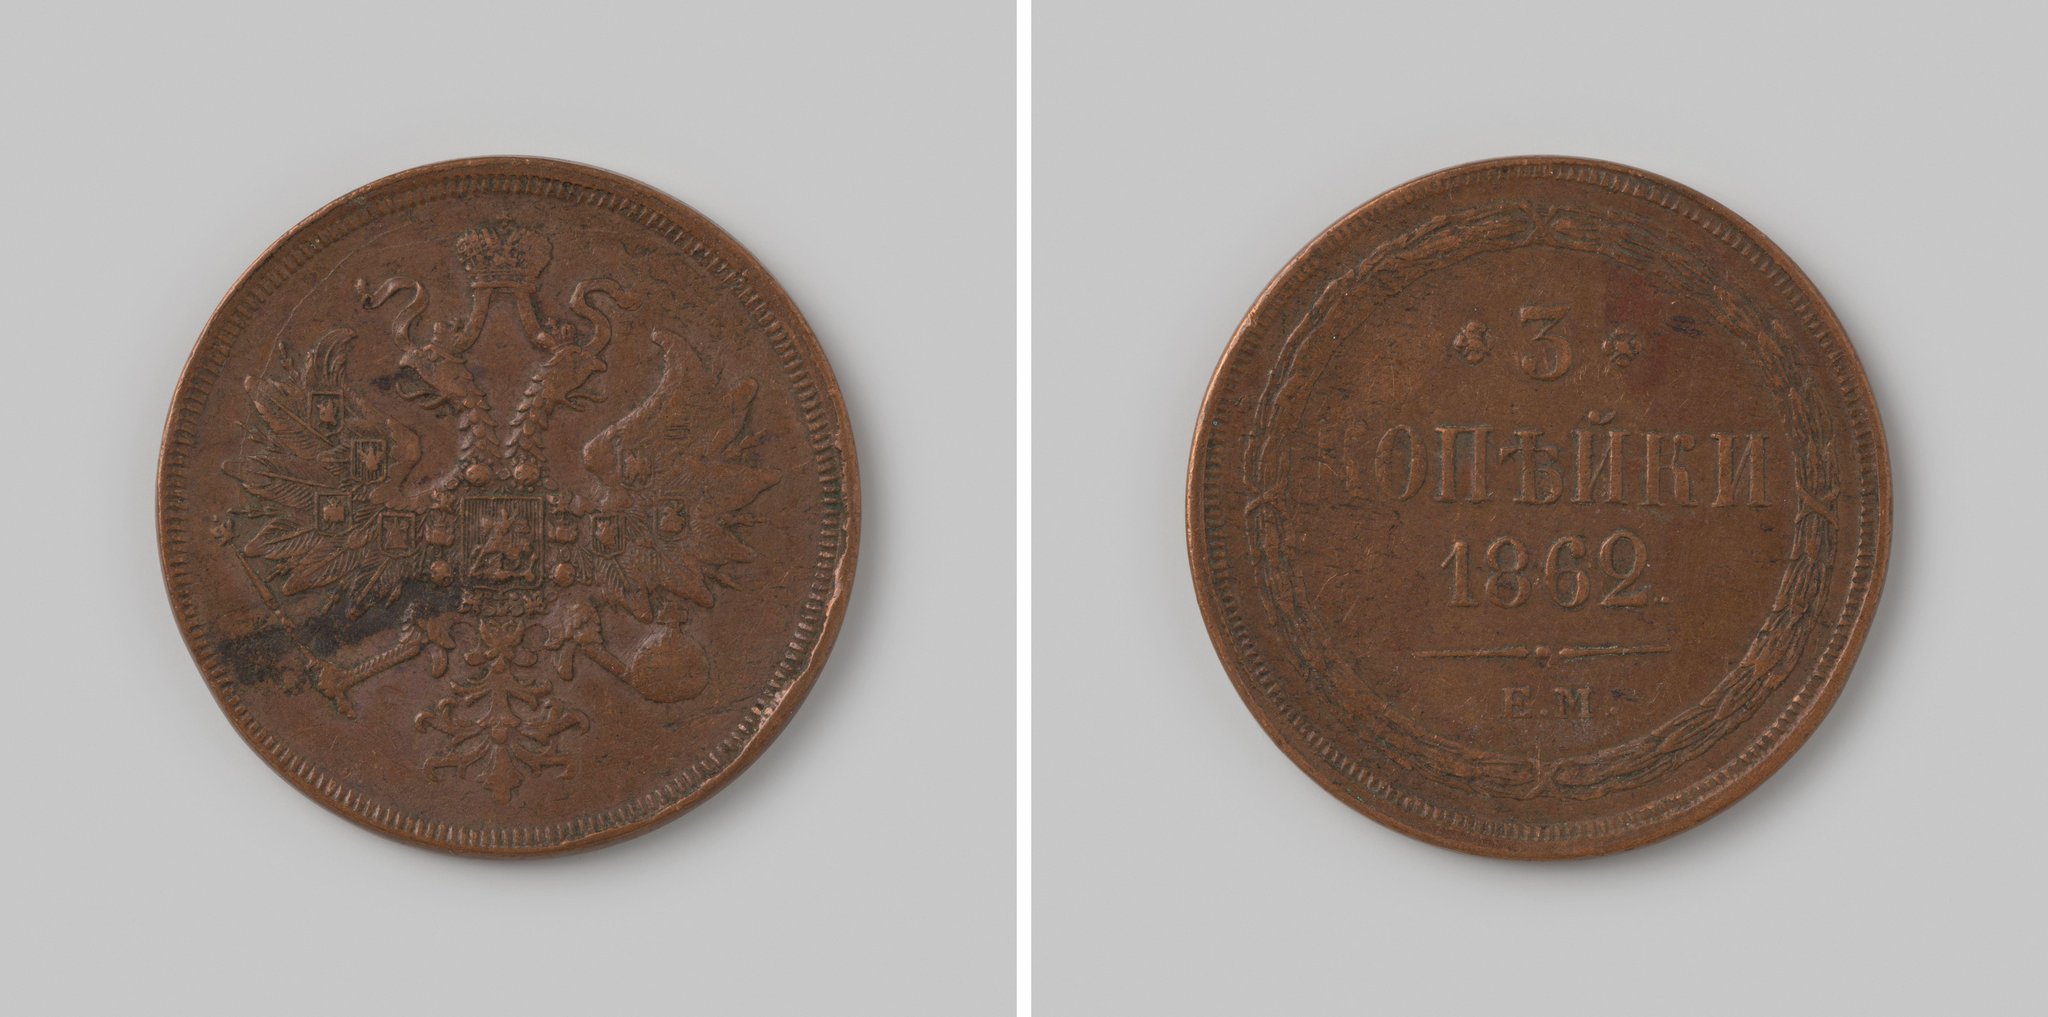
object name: coin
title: 3 kopeken uit Rusland van tsaar Alexander II, 1862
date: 1862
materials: copper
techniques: striking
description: Koperen munt. Voorzijde: dubbelkoppige gekroonde adelaar met gespreide vleugels en met op zijn vleugels kleine wapenschilden en op zijn borst een groot, met een ridderorde omhangen wapenschild en in zijn poten een scepter en een gekroonde bol. Boven de adelaar een kroon met lint. Keerzijde: binnen een krans van bladeren in twee regels waarde-aanduiding, waaronder jaartal. Daaronder in het Cyrillisch de letters E en M [=Ekaterinenburg]. Gladde rand.